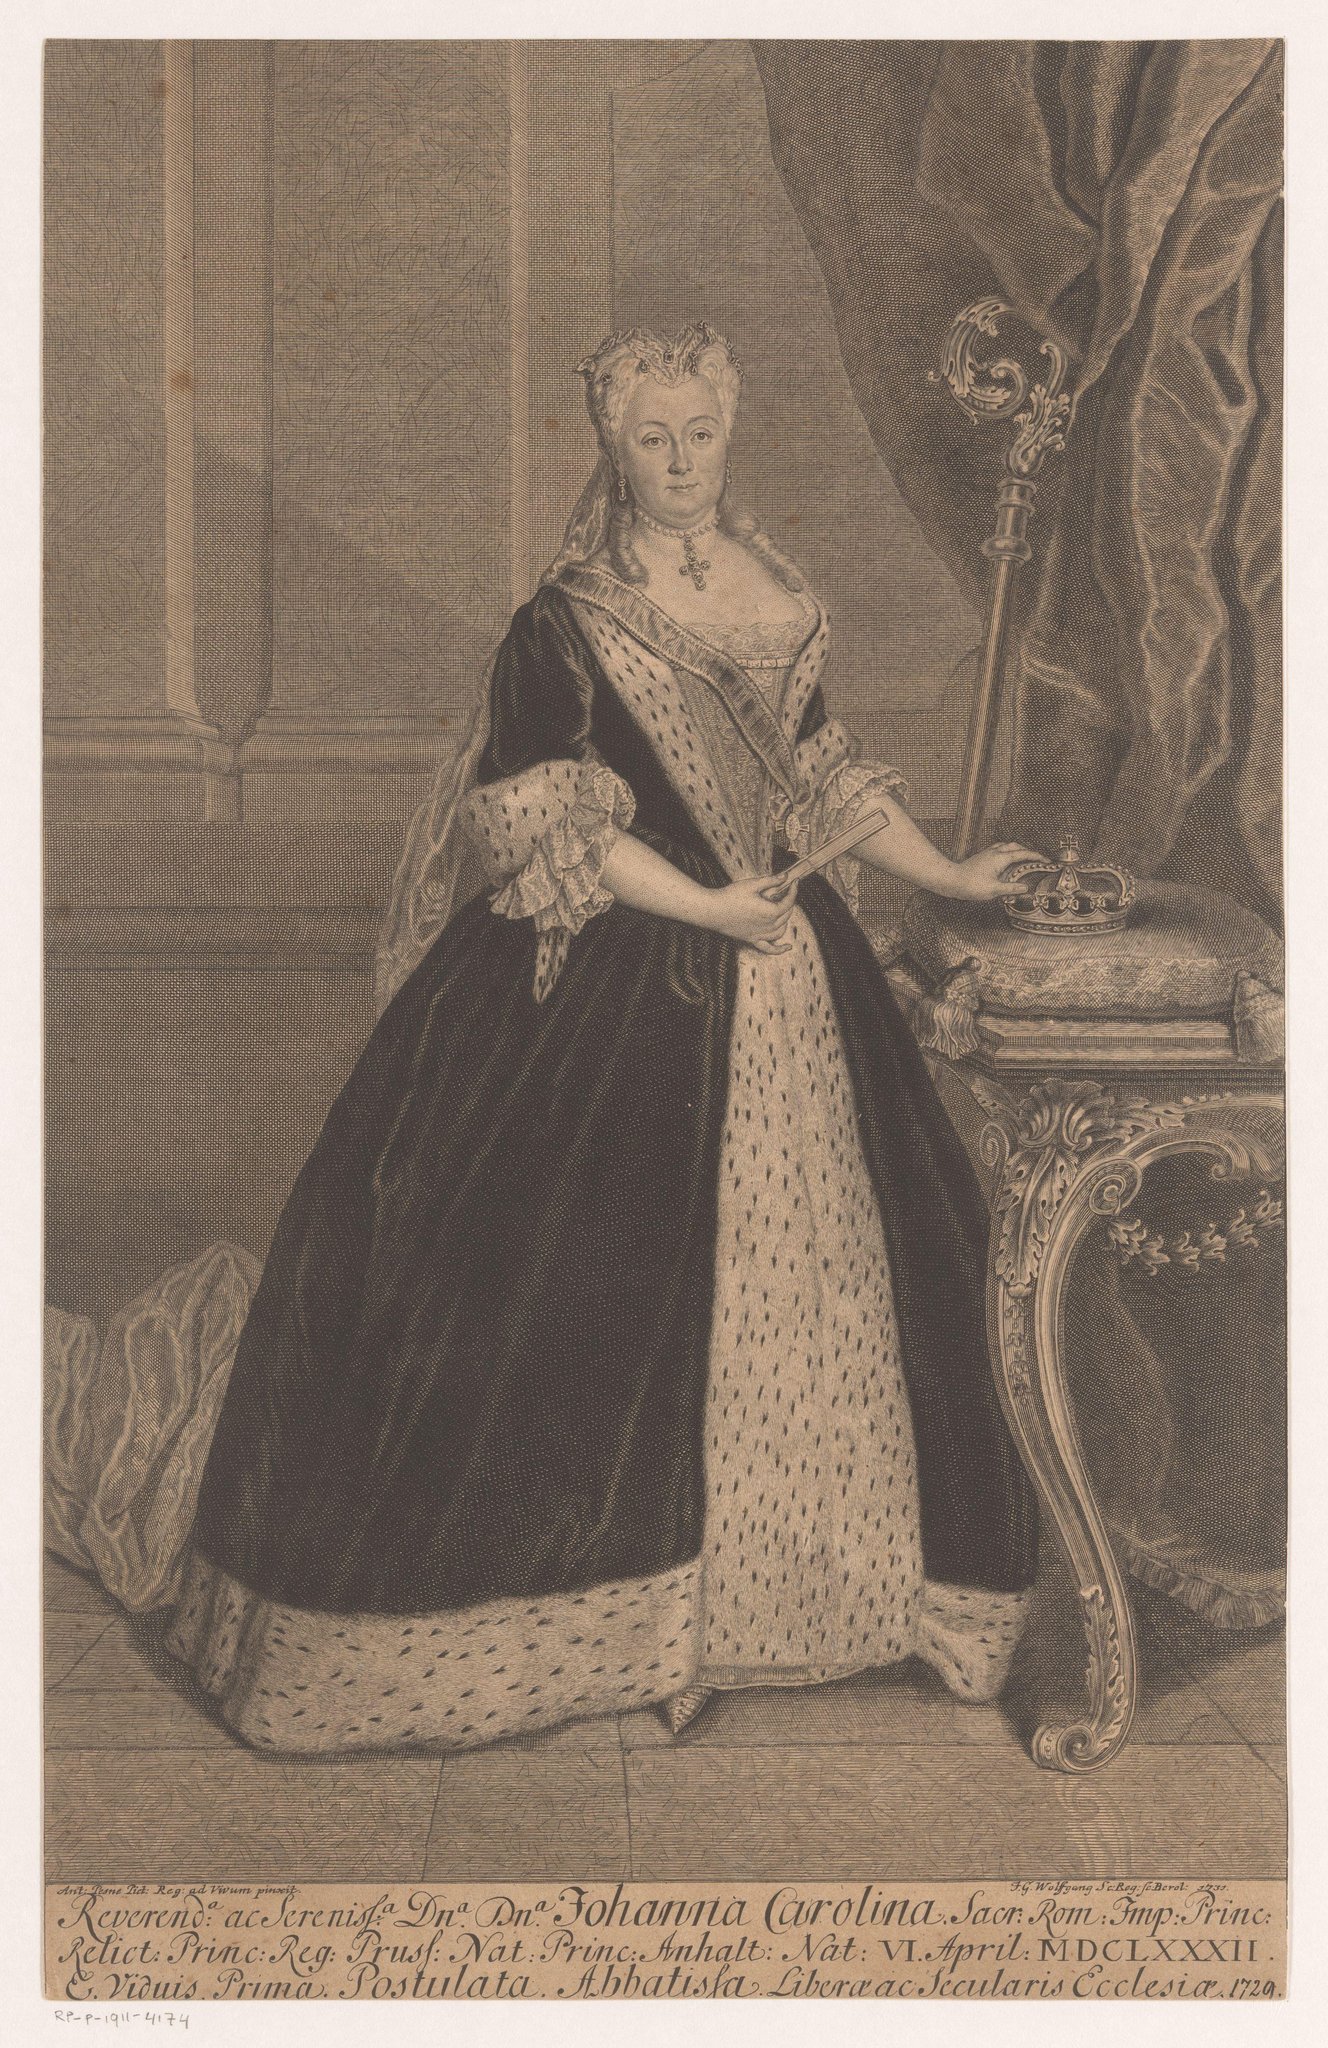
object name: print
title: Portret van Johanna Charlotte van Anhalt-Dessau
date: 1731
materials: paper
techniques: engraving, etching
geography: berlin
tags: historical persons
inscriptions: collector's mark: Lugt 2228